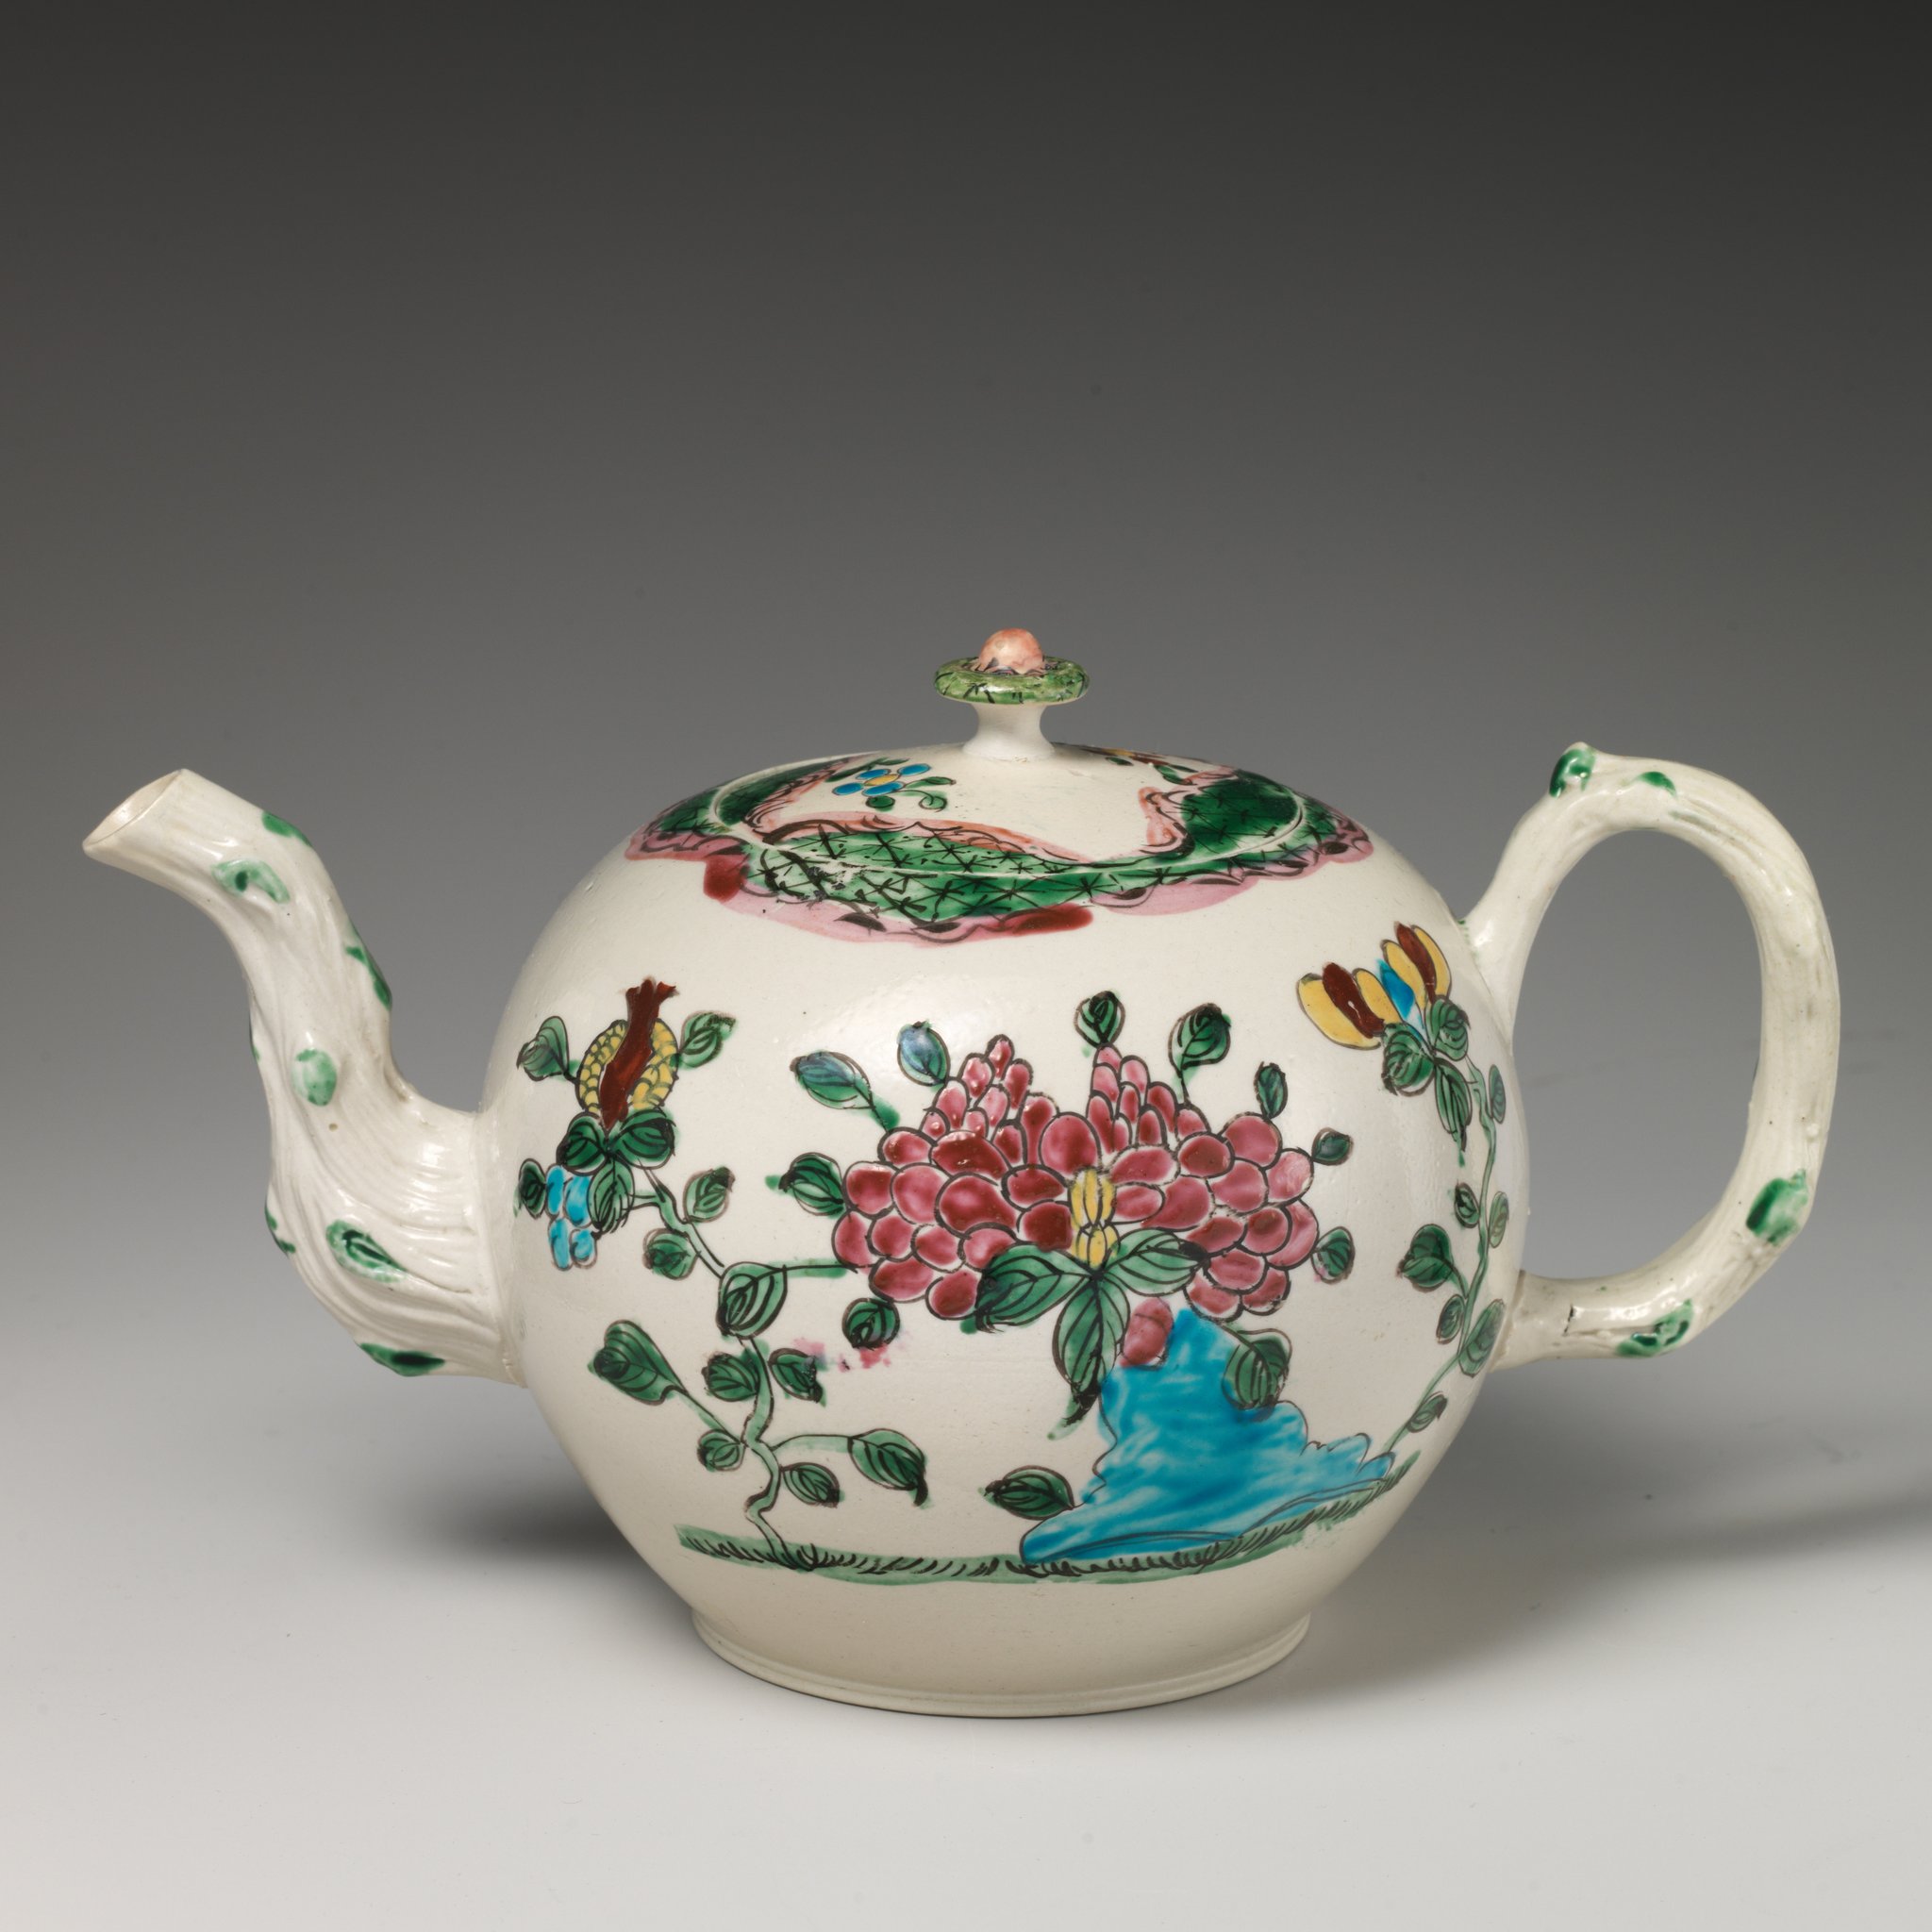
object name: teapot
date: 1765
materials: stoneware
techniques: salt glaze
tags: flowers